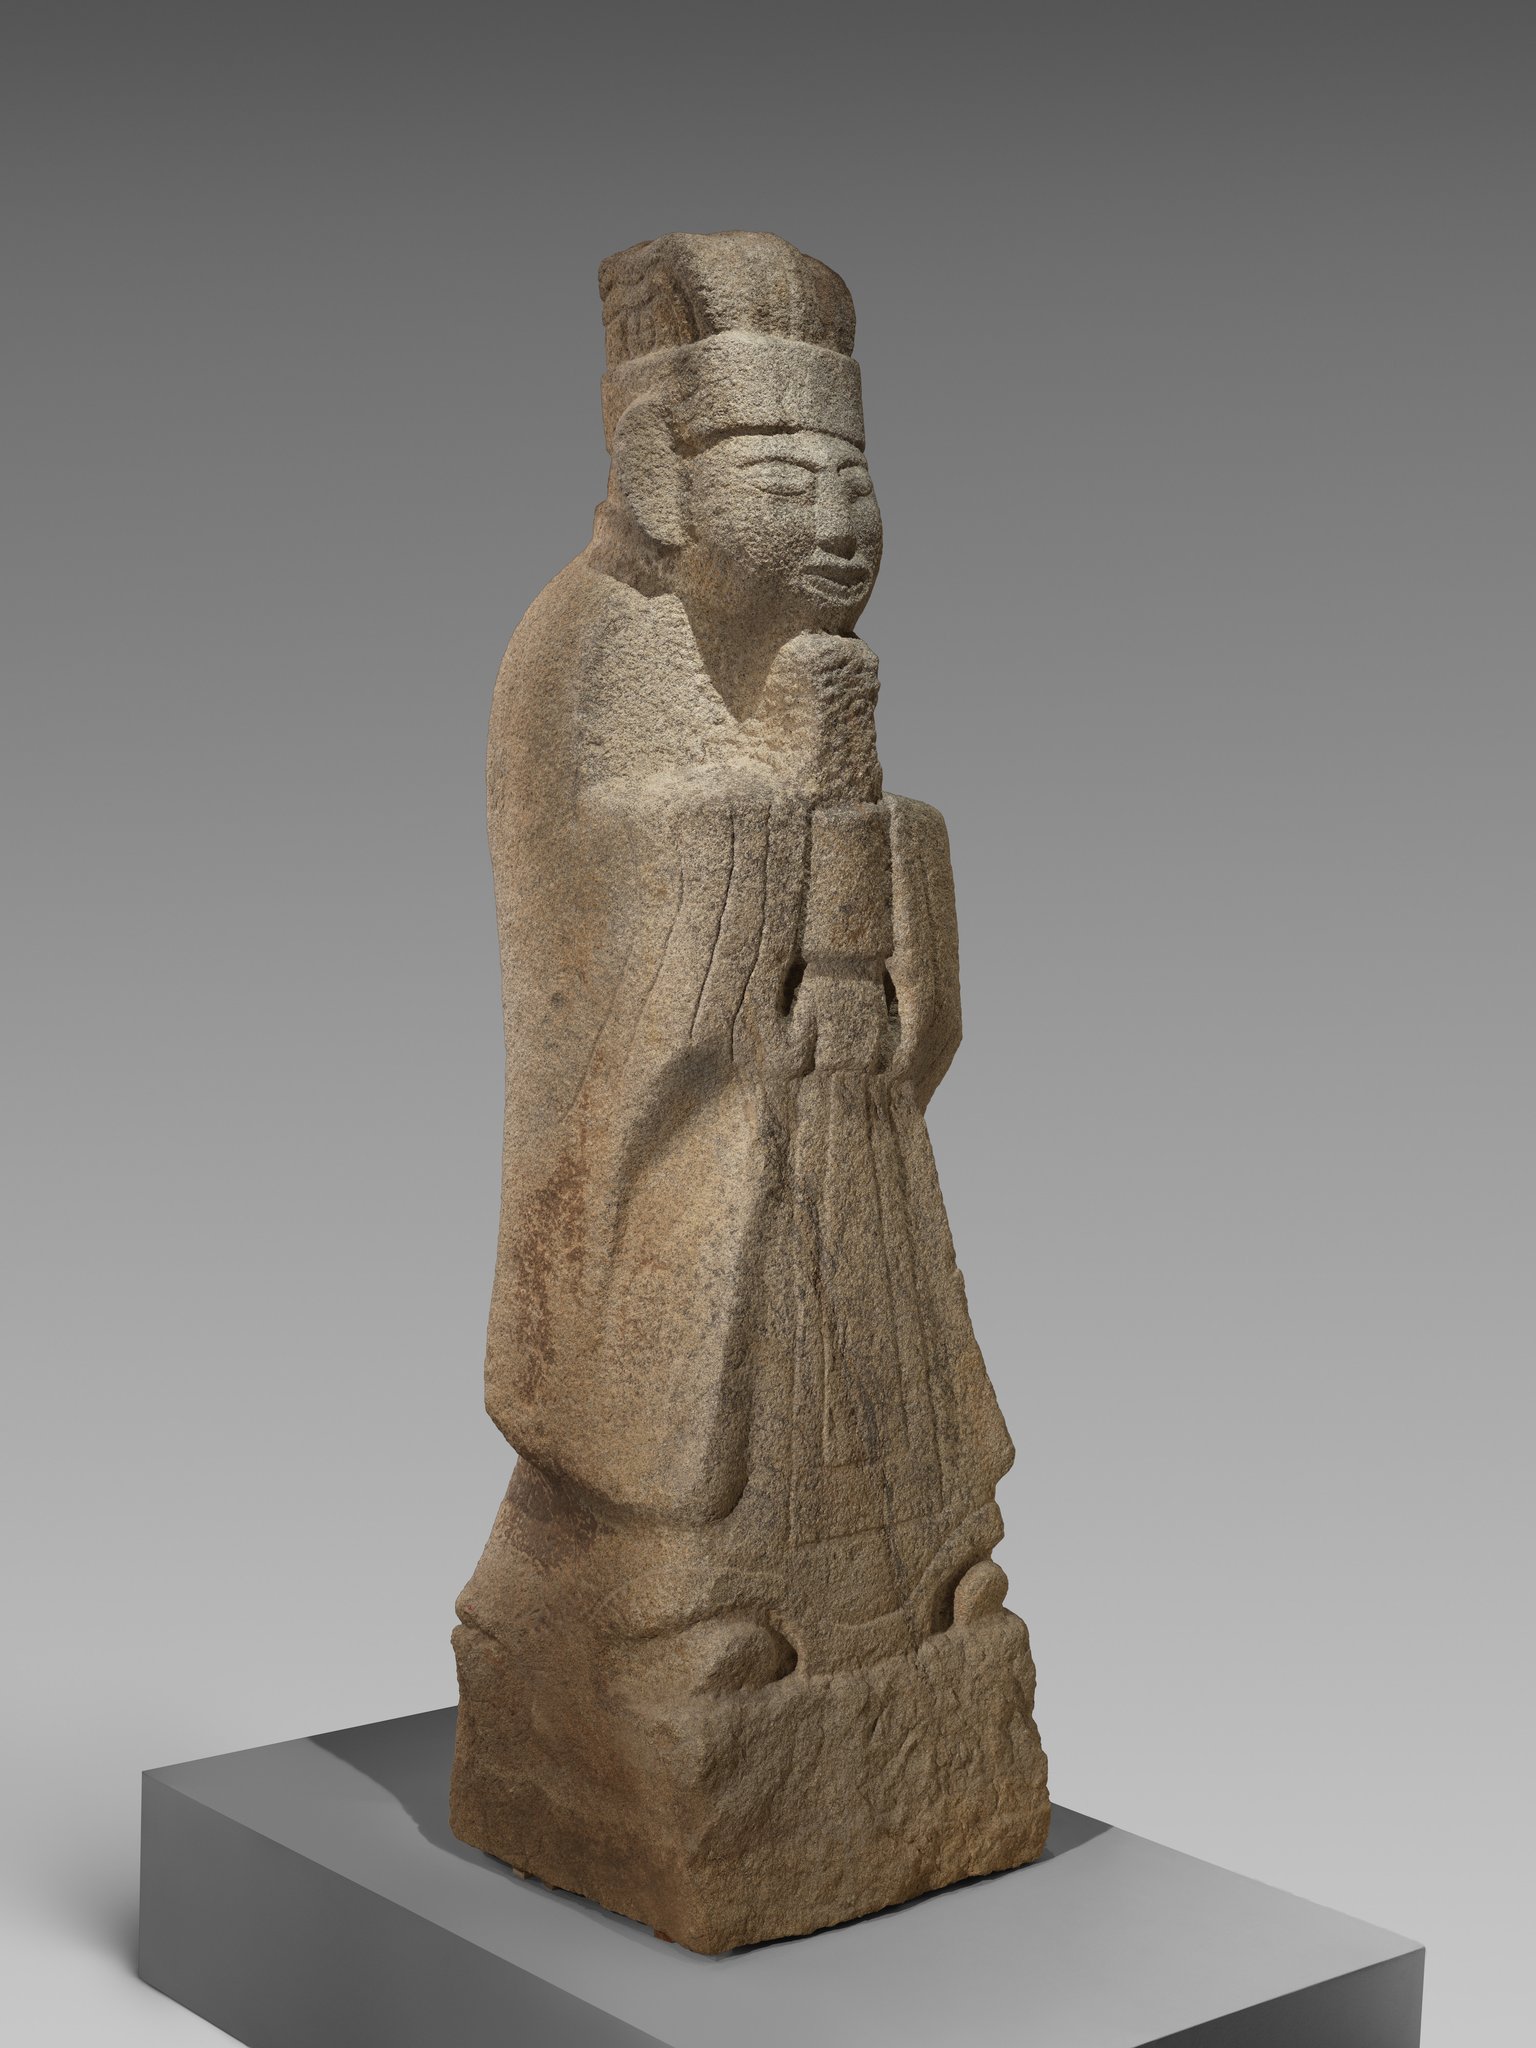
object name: figure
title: Tomb guardian in form of a civil official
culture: korean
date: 1801-1900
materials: granite